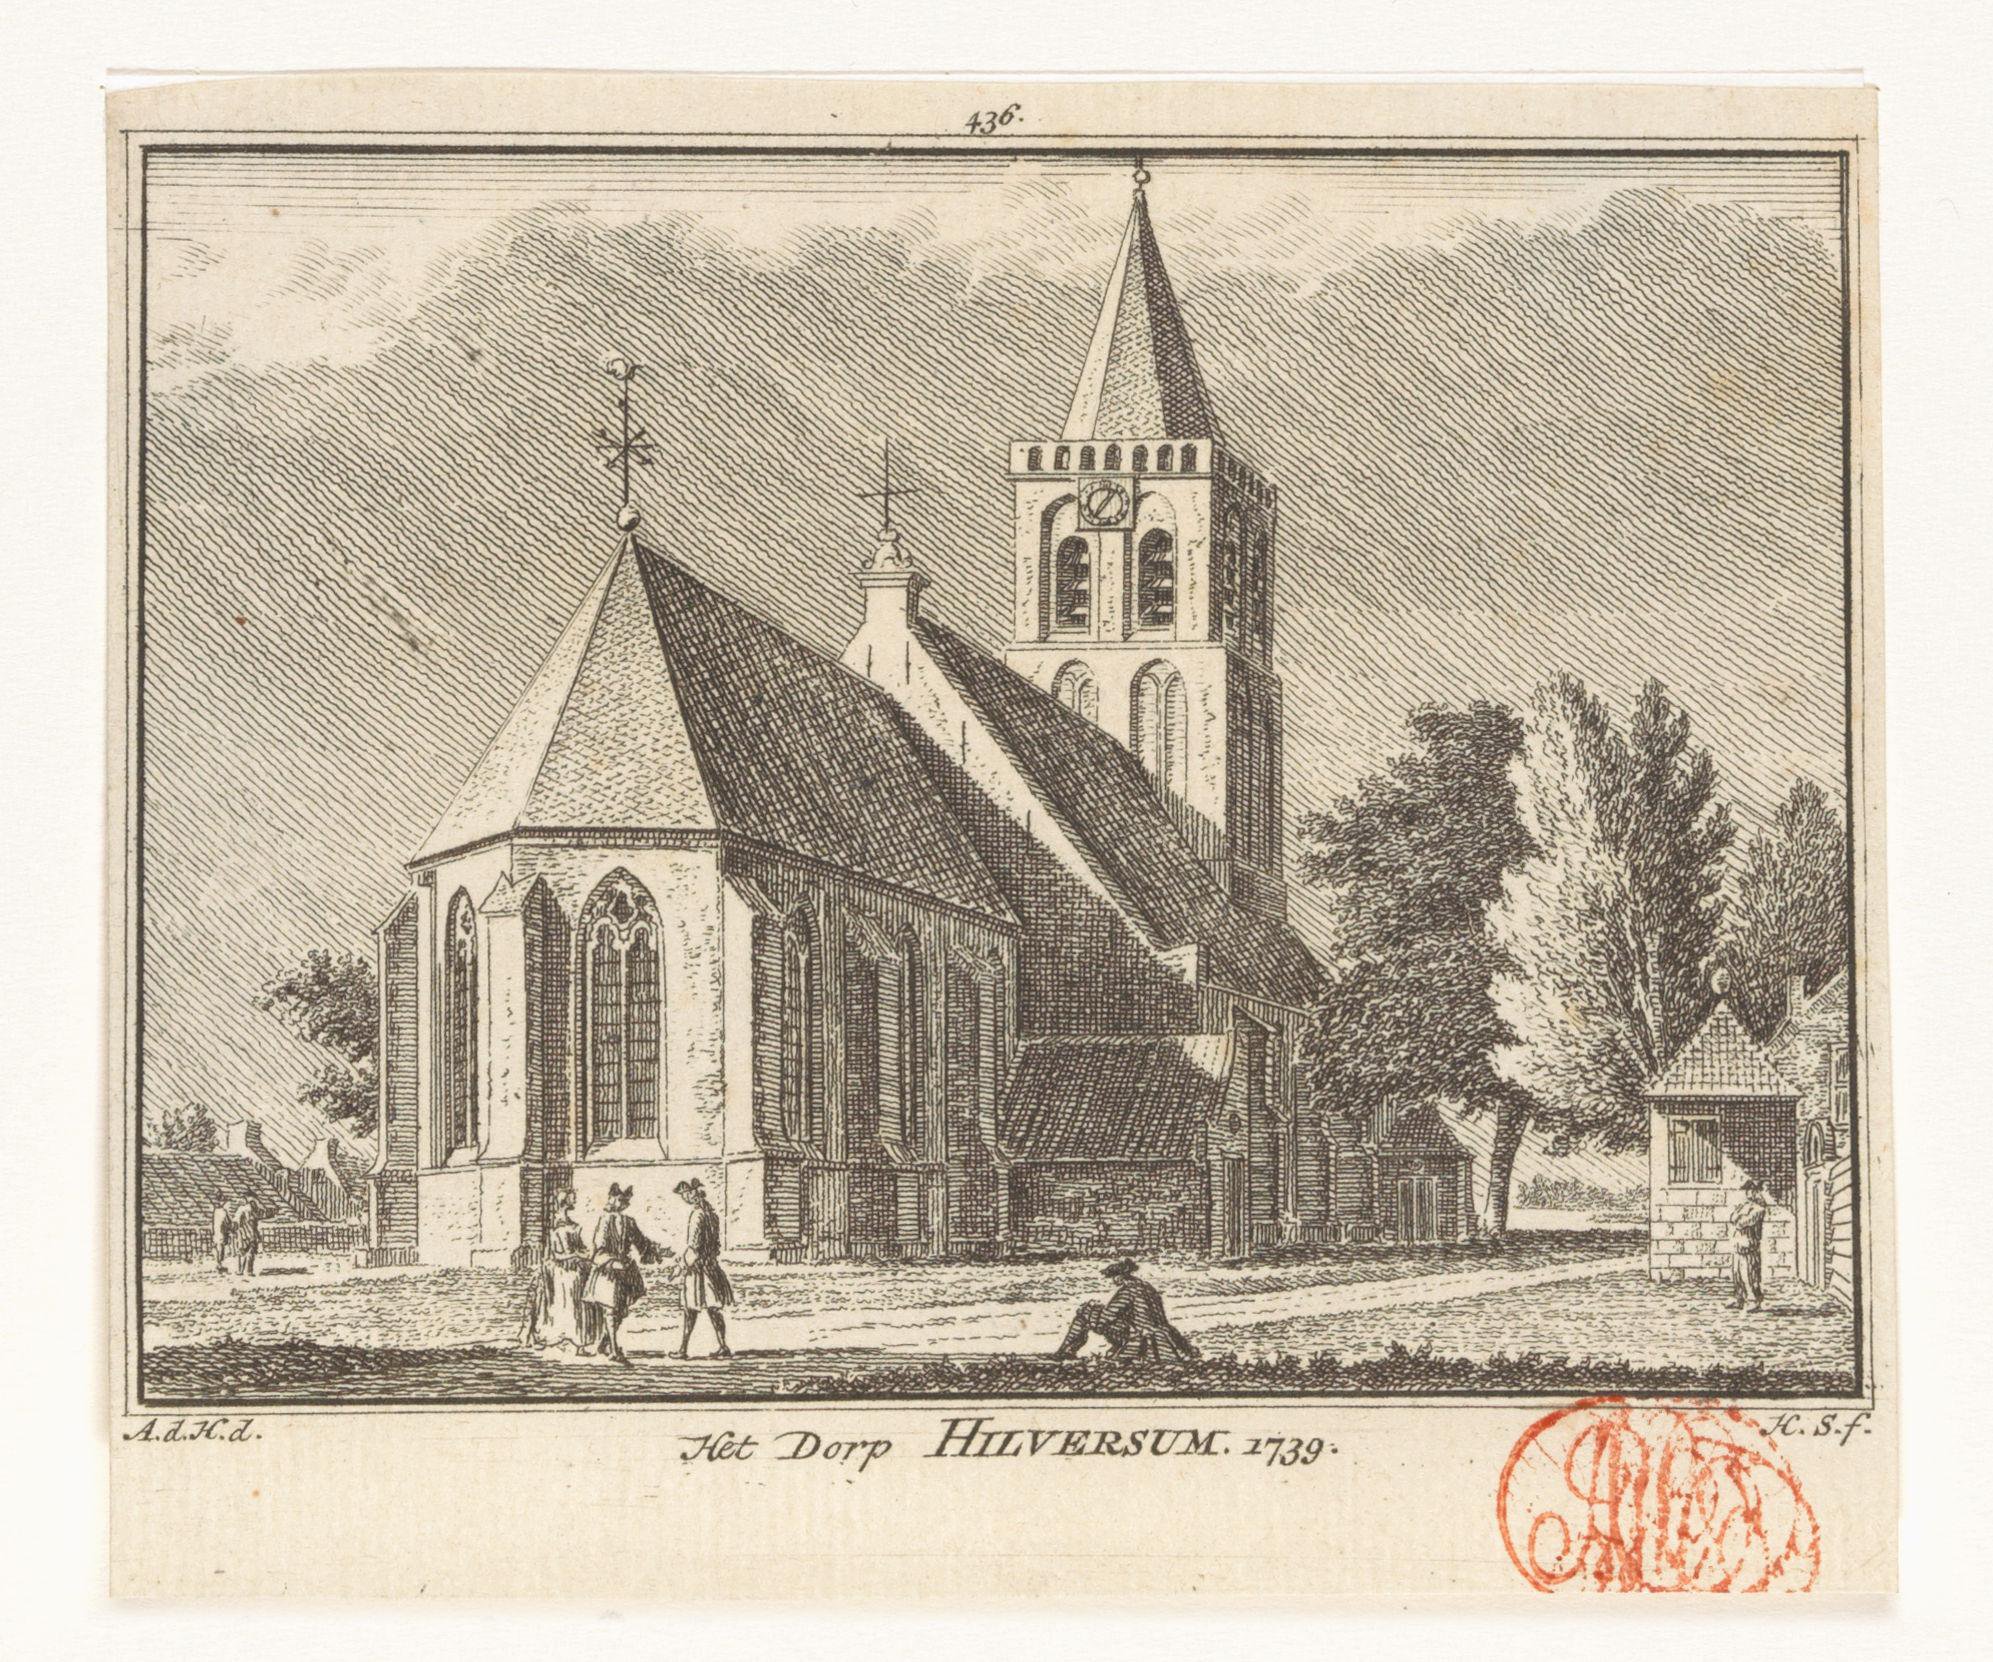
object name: book illustration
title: Het dorp Hilversum. 1739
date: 1757-1792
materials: paper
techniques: engraving, etching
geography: haarlem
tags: prospect of village, silhouette of village, church (exterior)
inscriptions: collector's mark: Lugt 195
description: Prent ook gebruikt in: Het verheerlykt Nederland of kabinet van hedendaagsche gezigten van steden, dorpen (…). 9 delen. Amsterdam: Isaak Tirion en weduwe Isaak Tirion, 1745-1774, dl. 6 (1757), ill. 436. Of in: Nederlandsche tafereelen; of eene keurige verzameling van negen honderd fraaije gezigten van steden, dorpen, sloten, oudheden (….). 9 delen. Amsterdam: Jan de Groot, 1792, dl. 6, ill. 436. Uit welke druk het huidige exemplaar precies komt is niet na te gaan.